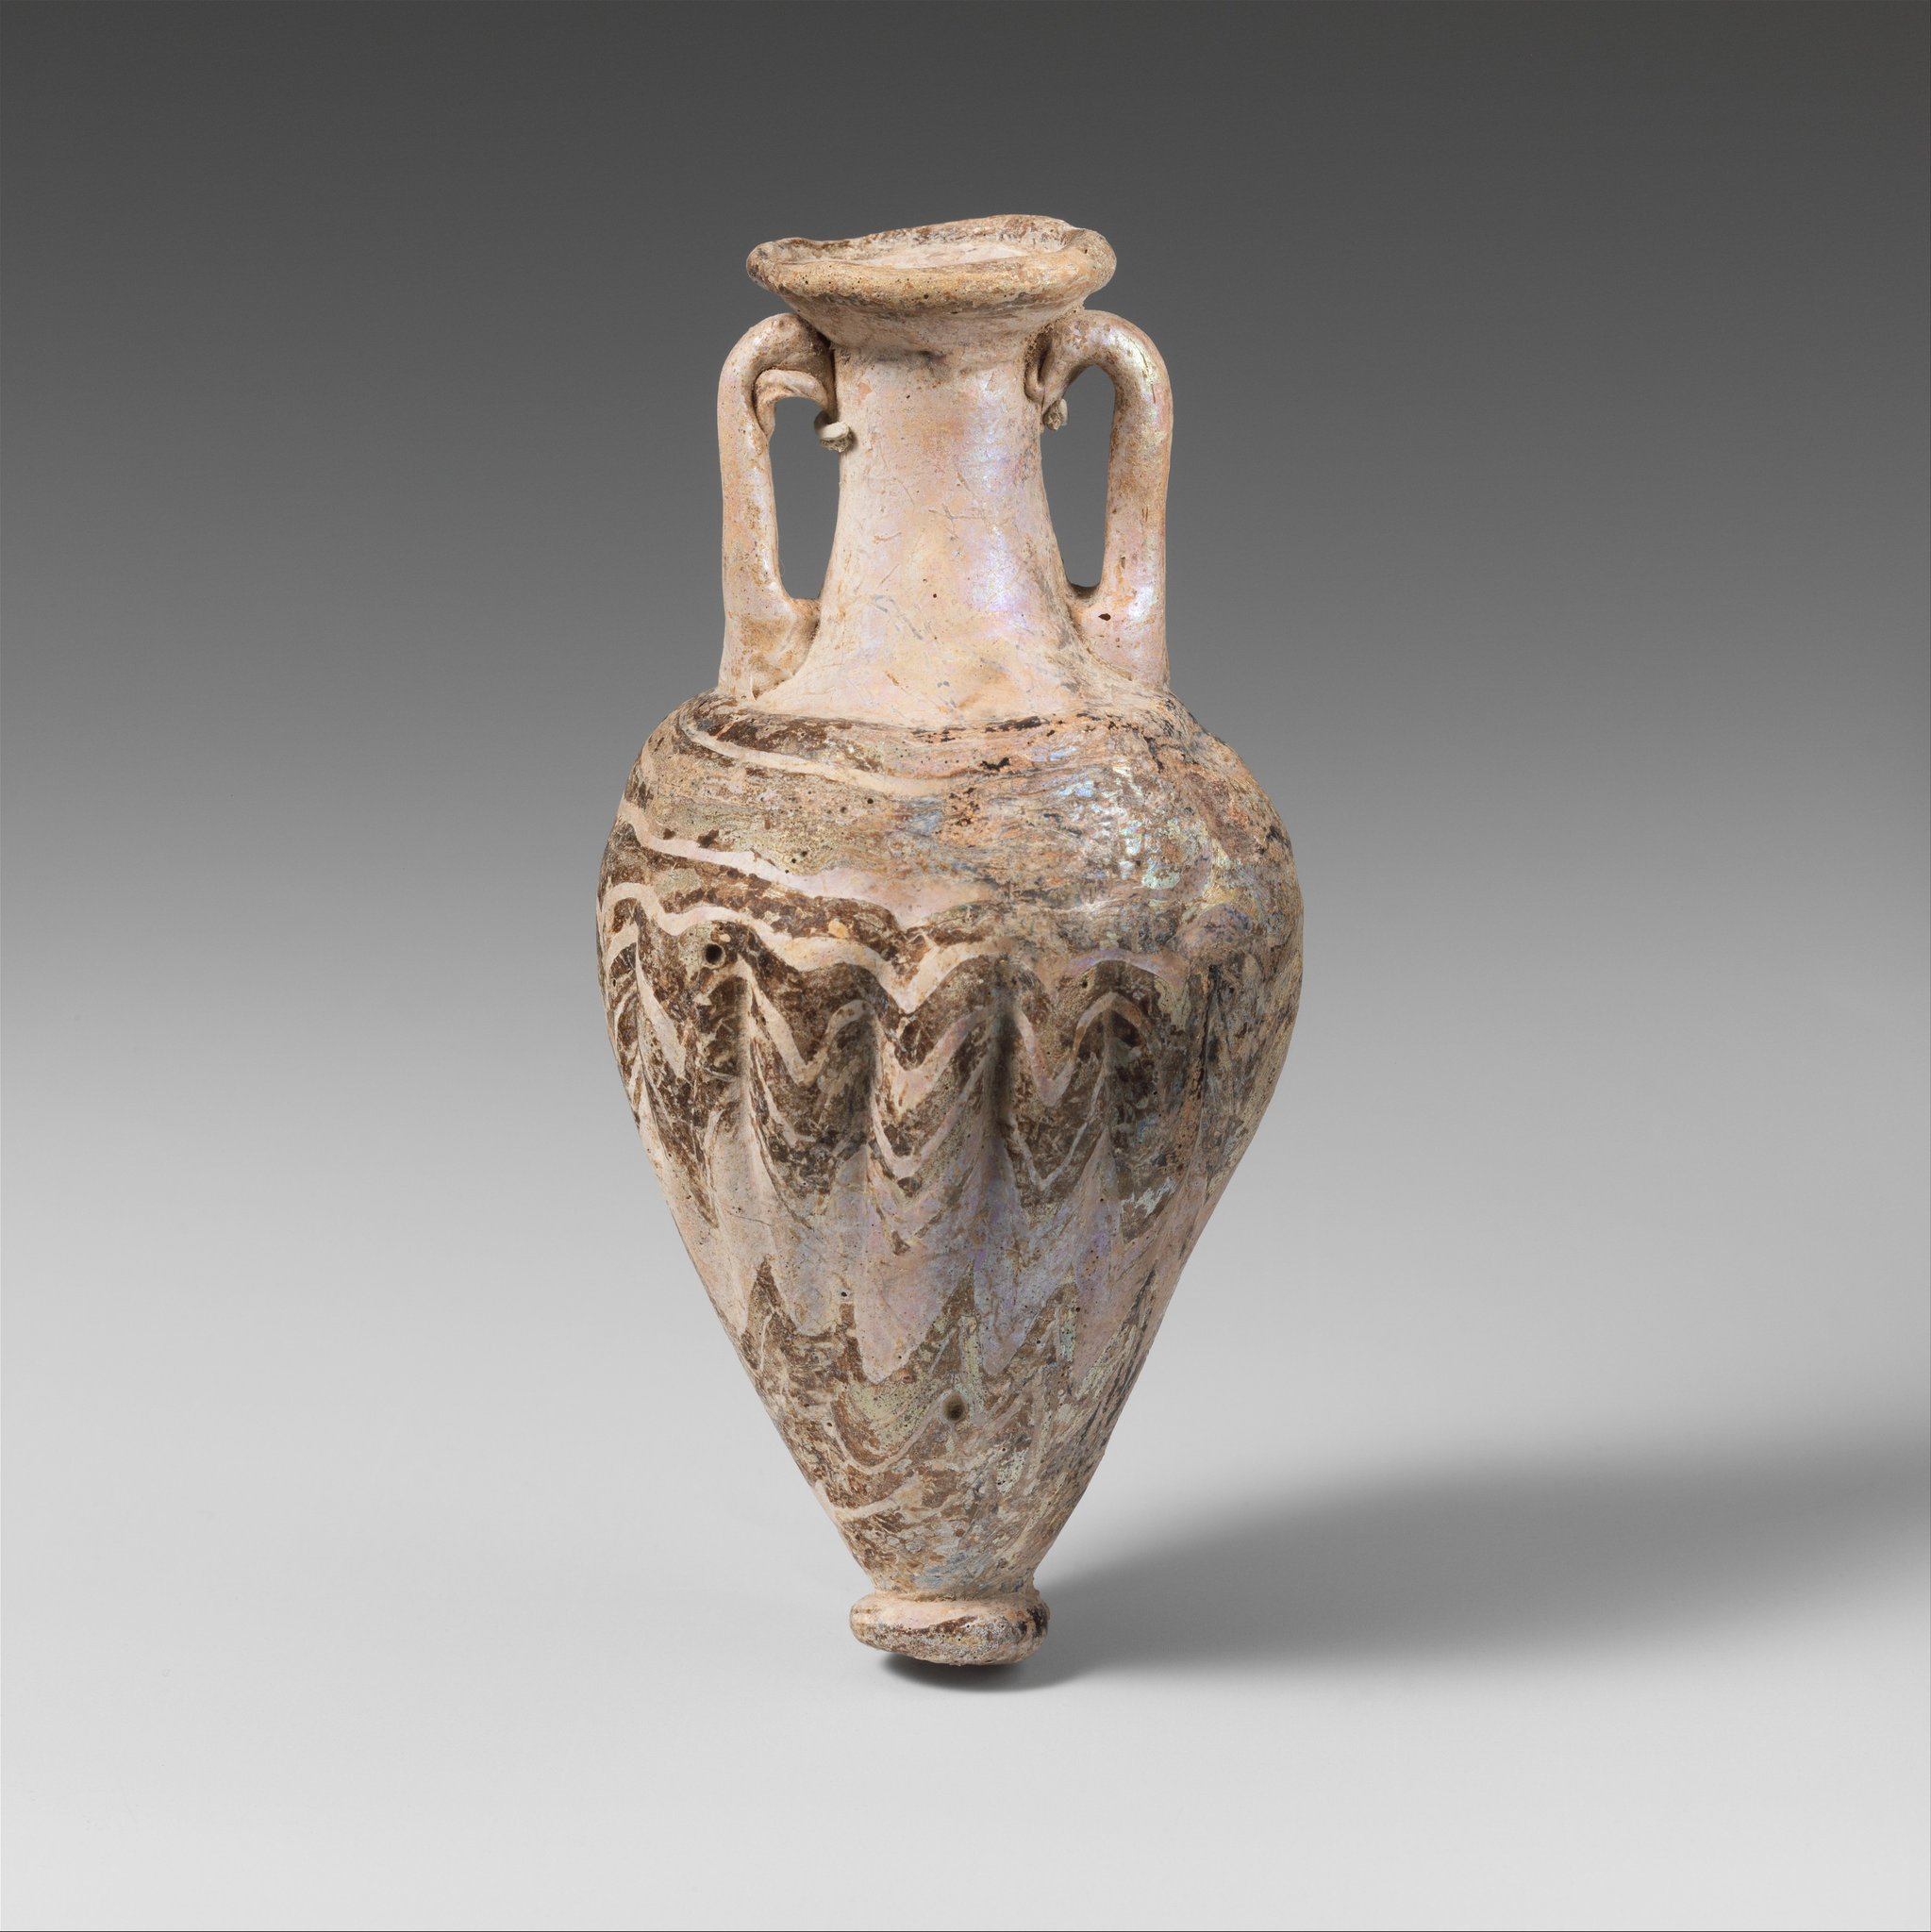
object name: amphoriskos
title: Glass amphoriskos (perfume bottle)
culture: greek, eastern mediterranean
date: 534-401 BCE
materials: glass